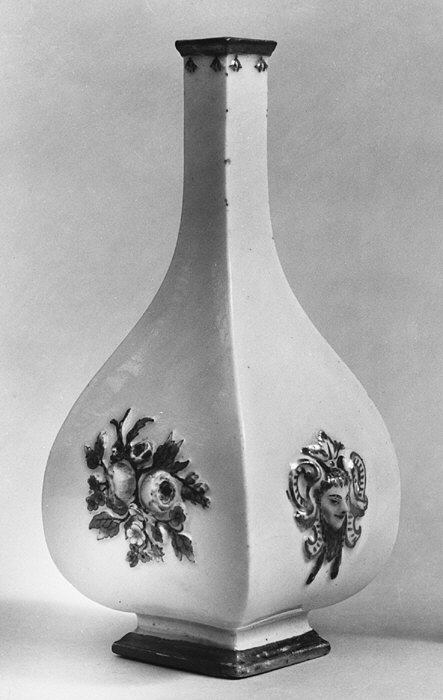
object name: vase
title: Vase (one of a pair)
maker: meissen manufactory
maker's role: manufactory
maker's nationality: german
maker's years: 1710-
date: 1713-1720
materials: hard paste porcelain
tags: faces,flowers